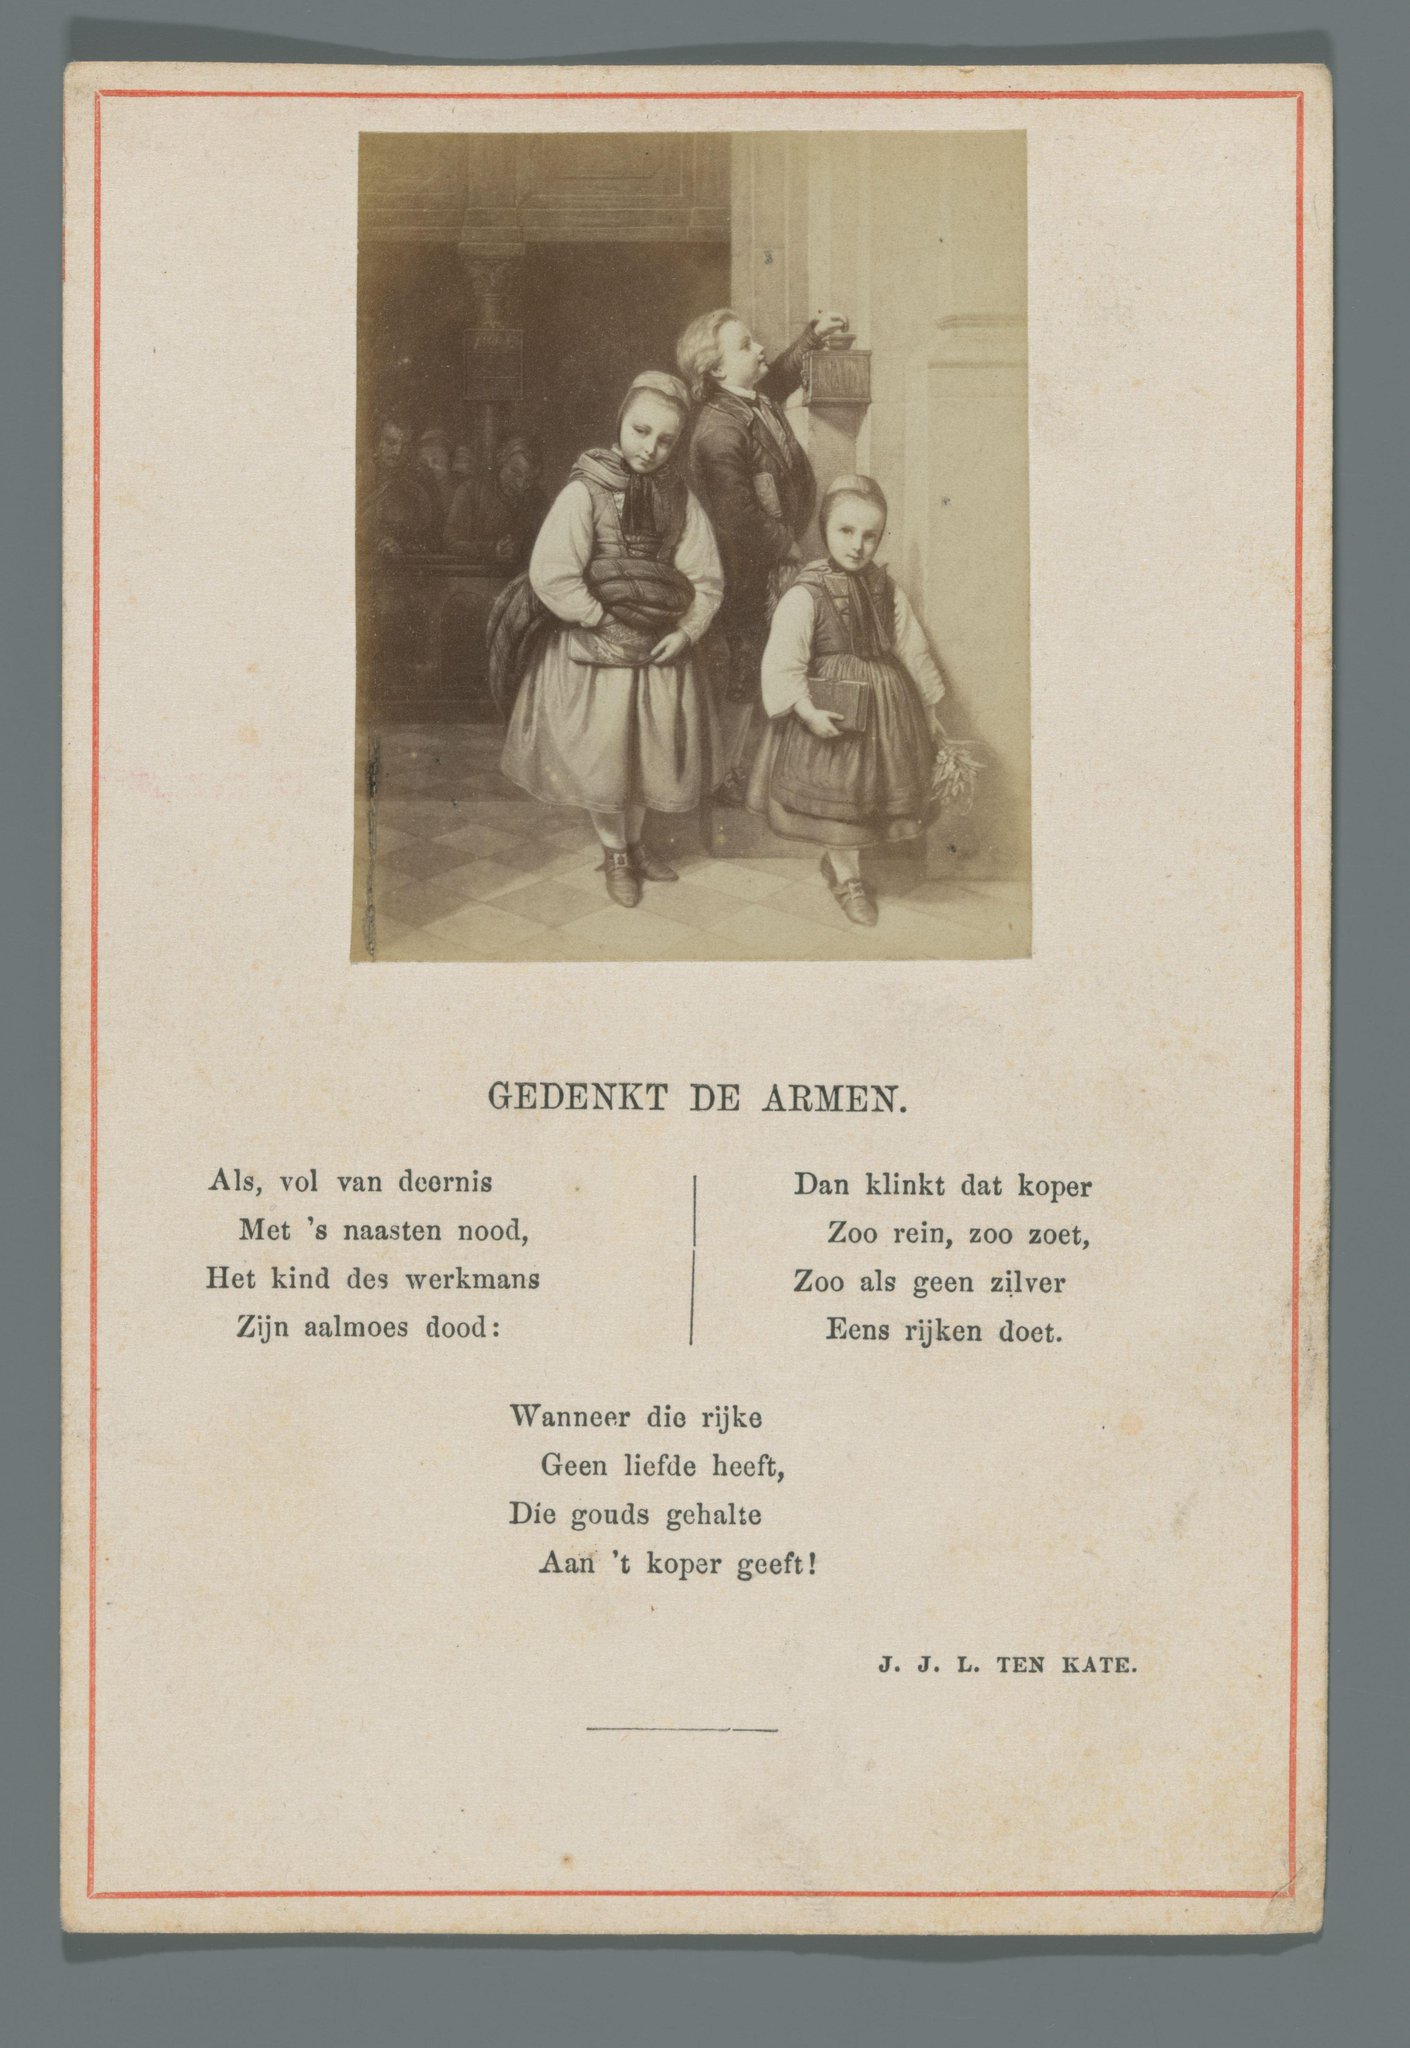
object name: photograph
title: Fotoreproductie van een schilderij naar het gedicht Gedenkt de armen door J.J.L. ten Kate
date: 1871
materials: cardboard, photographic support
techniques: albumen print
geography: amsterdam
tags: child (+ three persons)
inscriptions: inscription: ‘GEDENKT DE ARMEN./ (...) koper geeft!/ J. J. L. TEN KATE.’, number: ‘15’